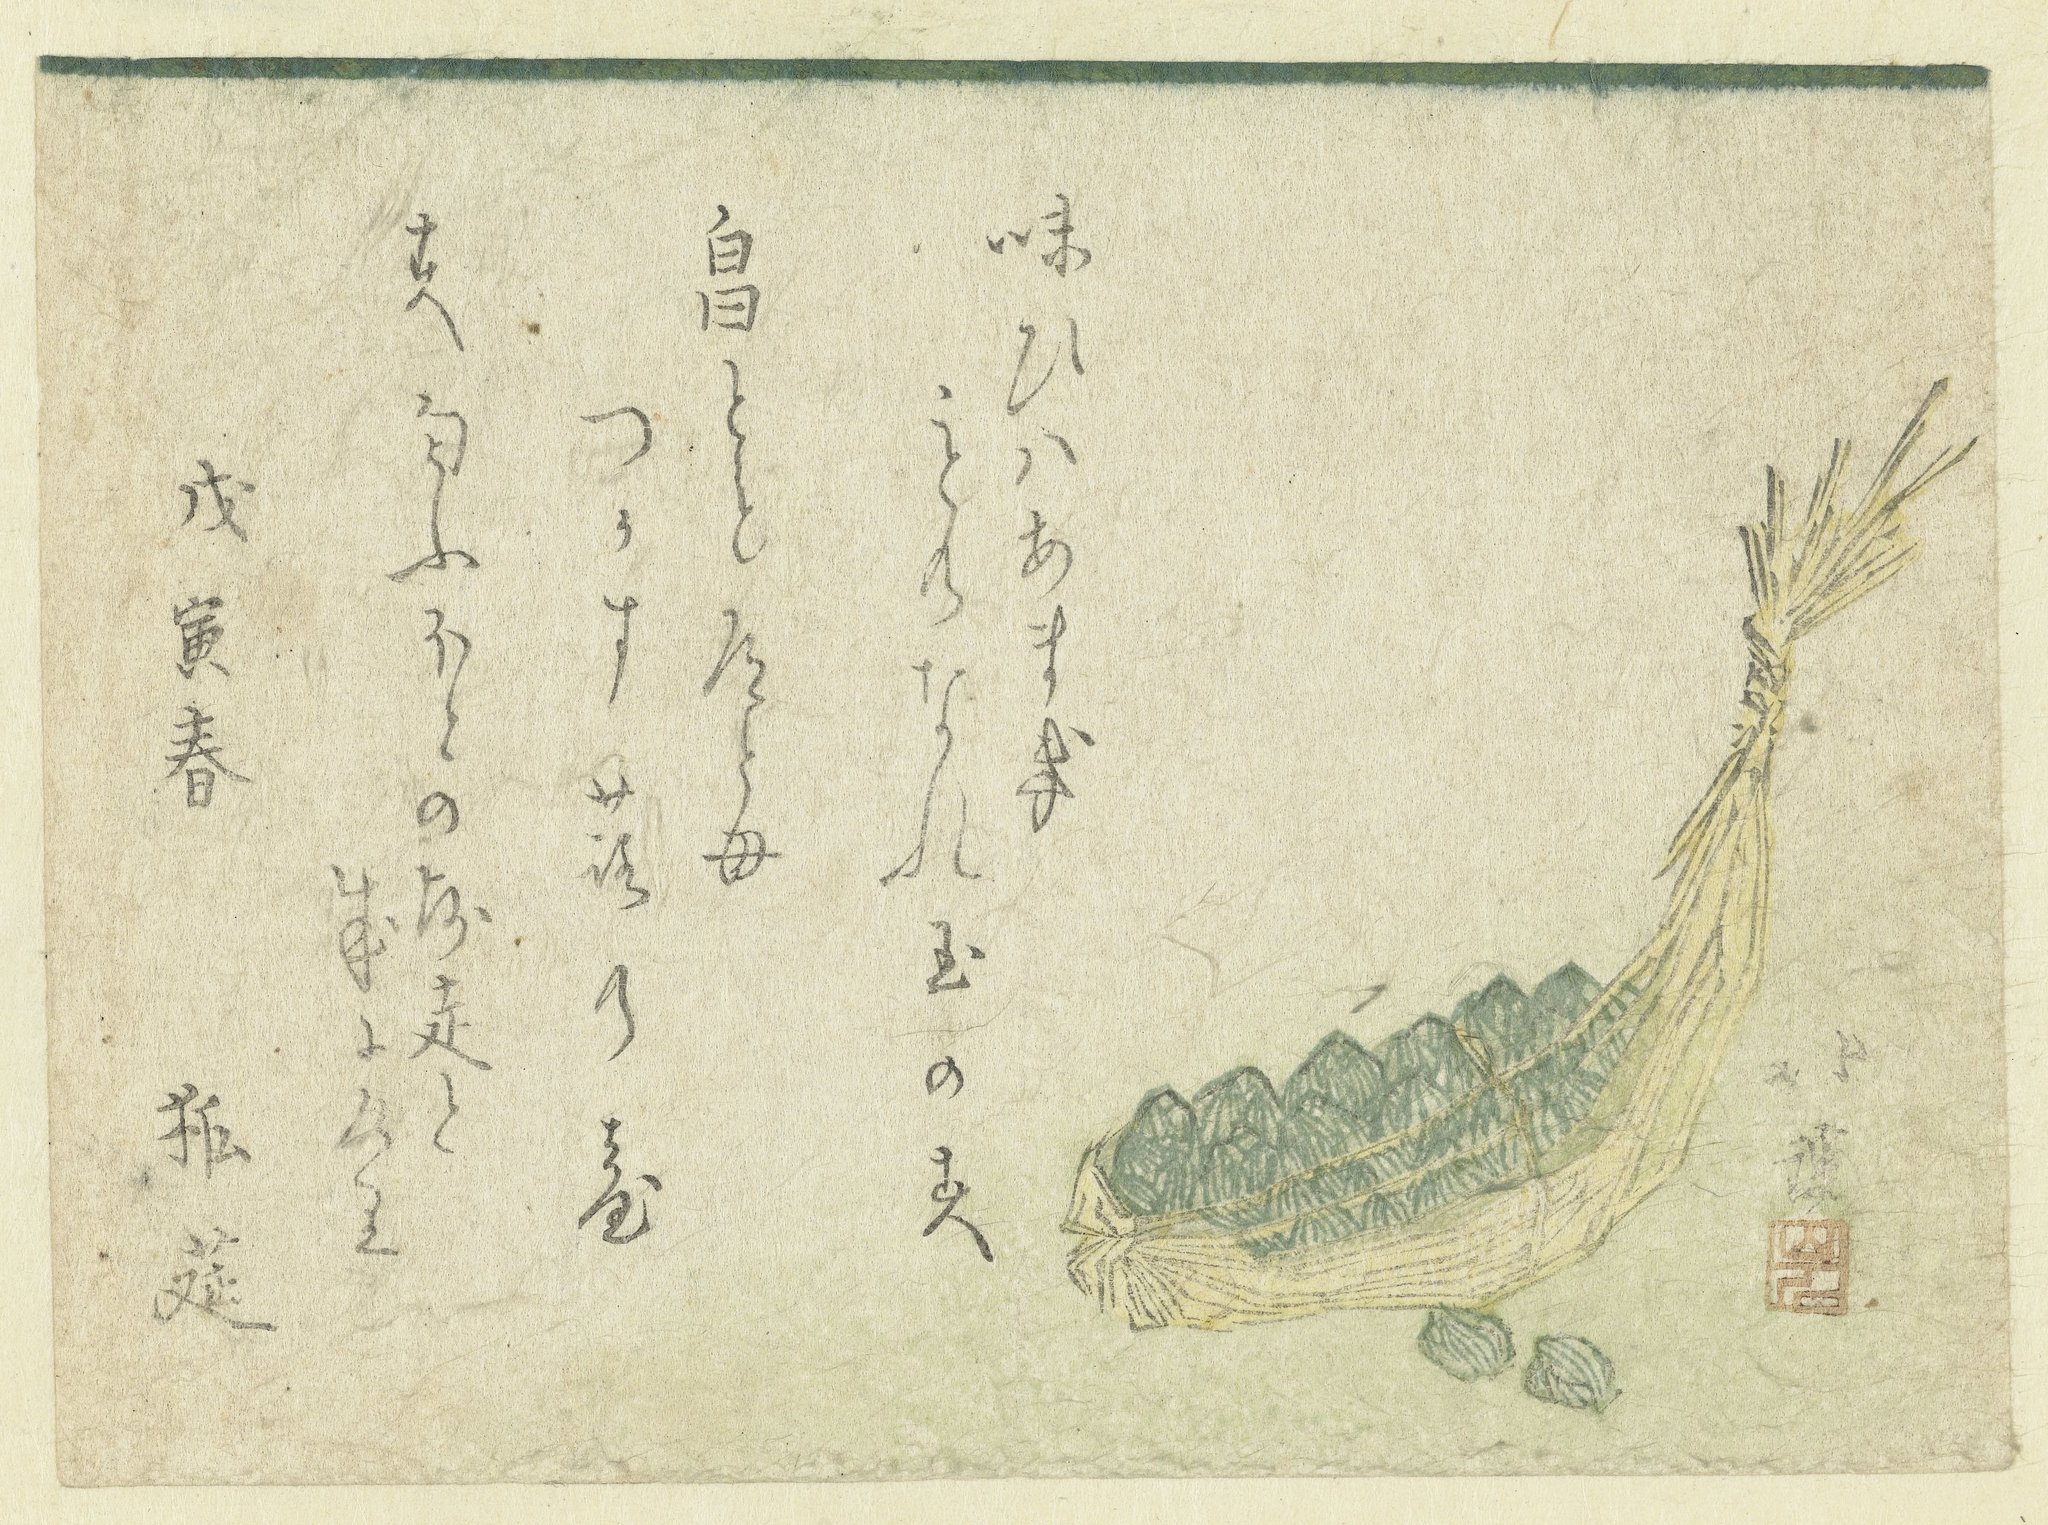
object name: surimono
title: Greens in a Straw Container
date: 1818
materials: paper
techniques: woodcut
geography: japan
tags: vegetables, agricultural products and by-products: straw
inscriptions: stamp, verso, stamped: Paper crane.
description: Een surimono is een luxe uitgevoerde prent waarop beeld met één of meerdere gedichten gecombineerd is. Bij het drukken van een surimono werd vaak gebruik gemaakt van dikker papier, blinddruk en metaal pigmenten, zoals koper- en zilverpoeder. De prenten werden vaak in opdracht van dichters gemaakt en als exclusief geschenk aan vrienden en relaties gegeven.